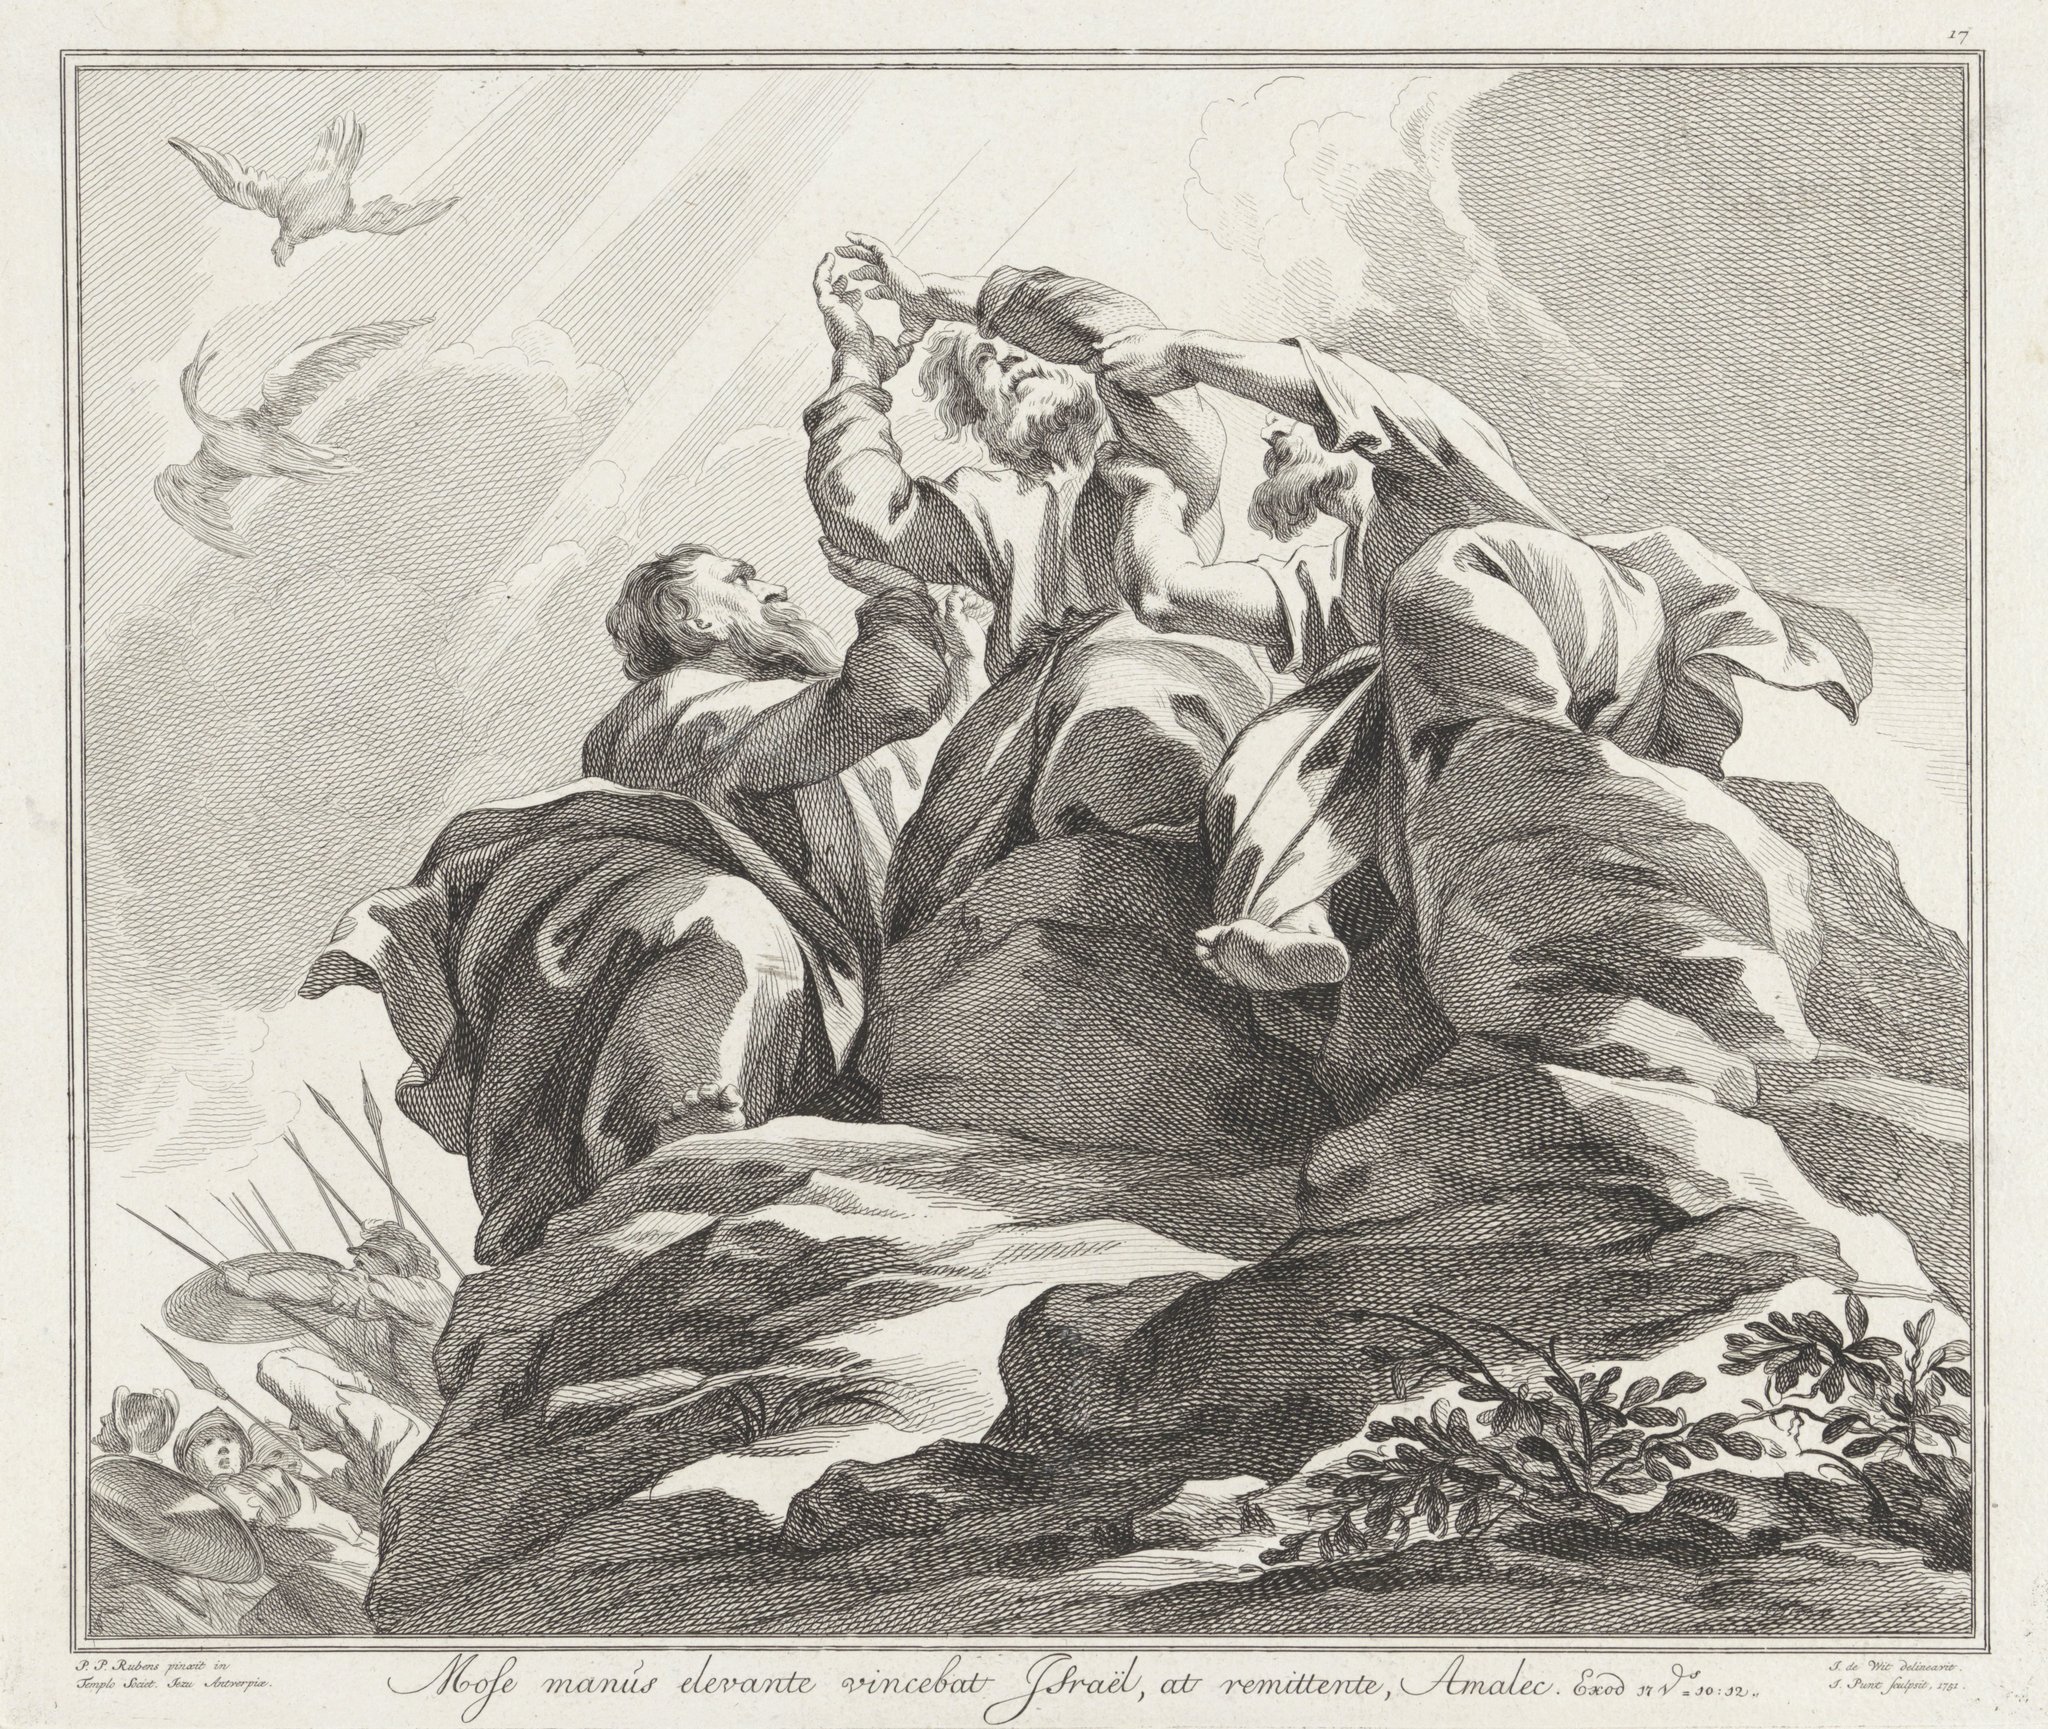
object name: print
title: Les plat-fonds ou les tableaux des galeries / De plafonds of gallerystukken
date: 1751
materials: paper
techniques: engraving, etching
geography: amsterdam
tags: moses goes to the top of a hill with aaron and hur and raises his arms to make the israelites victorious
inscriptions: date: ‘1751’, collector's mark: Lugt 240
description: Mozes' armen worden omhooggehouden door Aäron en Hur. Onder de rechthoekige voorstelling een vers in het Latijn uit Ex. 17:10-12.